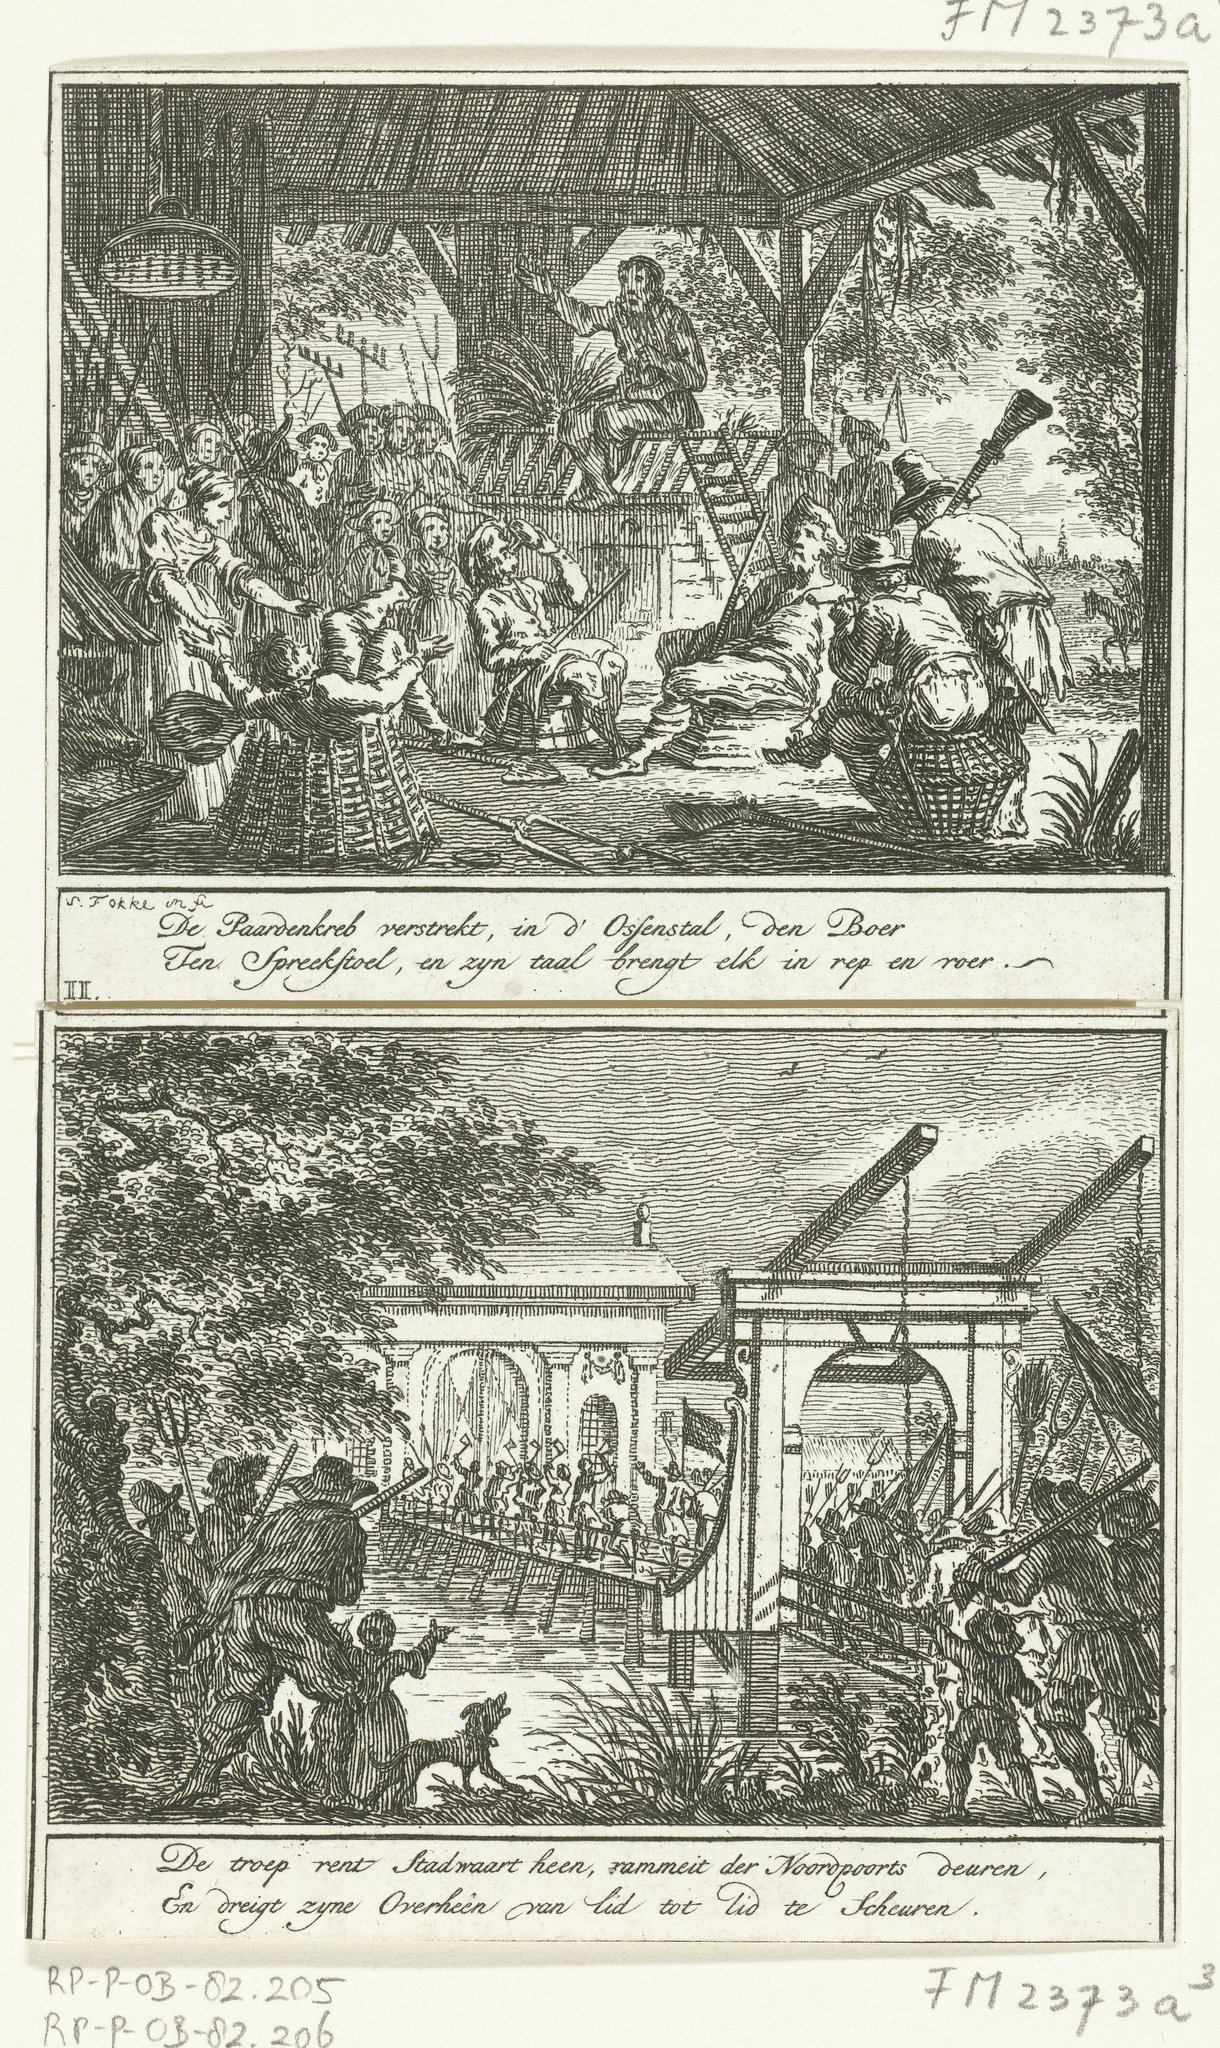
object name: print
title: Het preken van oproer onder de boeren, 1672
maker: simon fokke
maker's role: draughtsman, print maker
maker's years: 1712-1784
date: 1764-1766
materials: paper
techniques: etching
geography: northern netherlands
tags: middelburg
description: Het preken van oproer onder de boeren in een boerenschuur, 1672. Met onderschrift van twee regels. Illustratie nr. II bij een gedicht van Petrus Johannes Beronicius over de opstandige Zeeuwse boeren en het tumult te Middelburg rond burgemeester Filips van den Brande op 21 juli 1672.